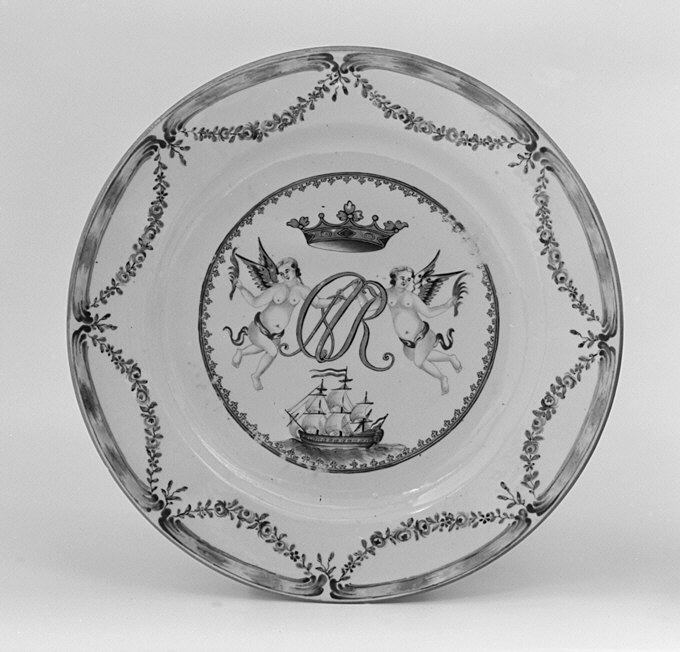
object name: plate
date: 1750-1770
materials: hard paste porcelain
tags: angels,insignia,ships